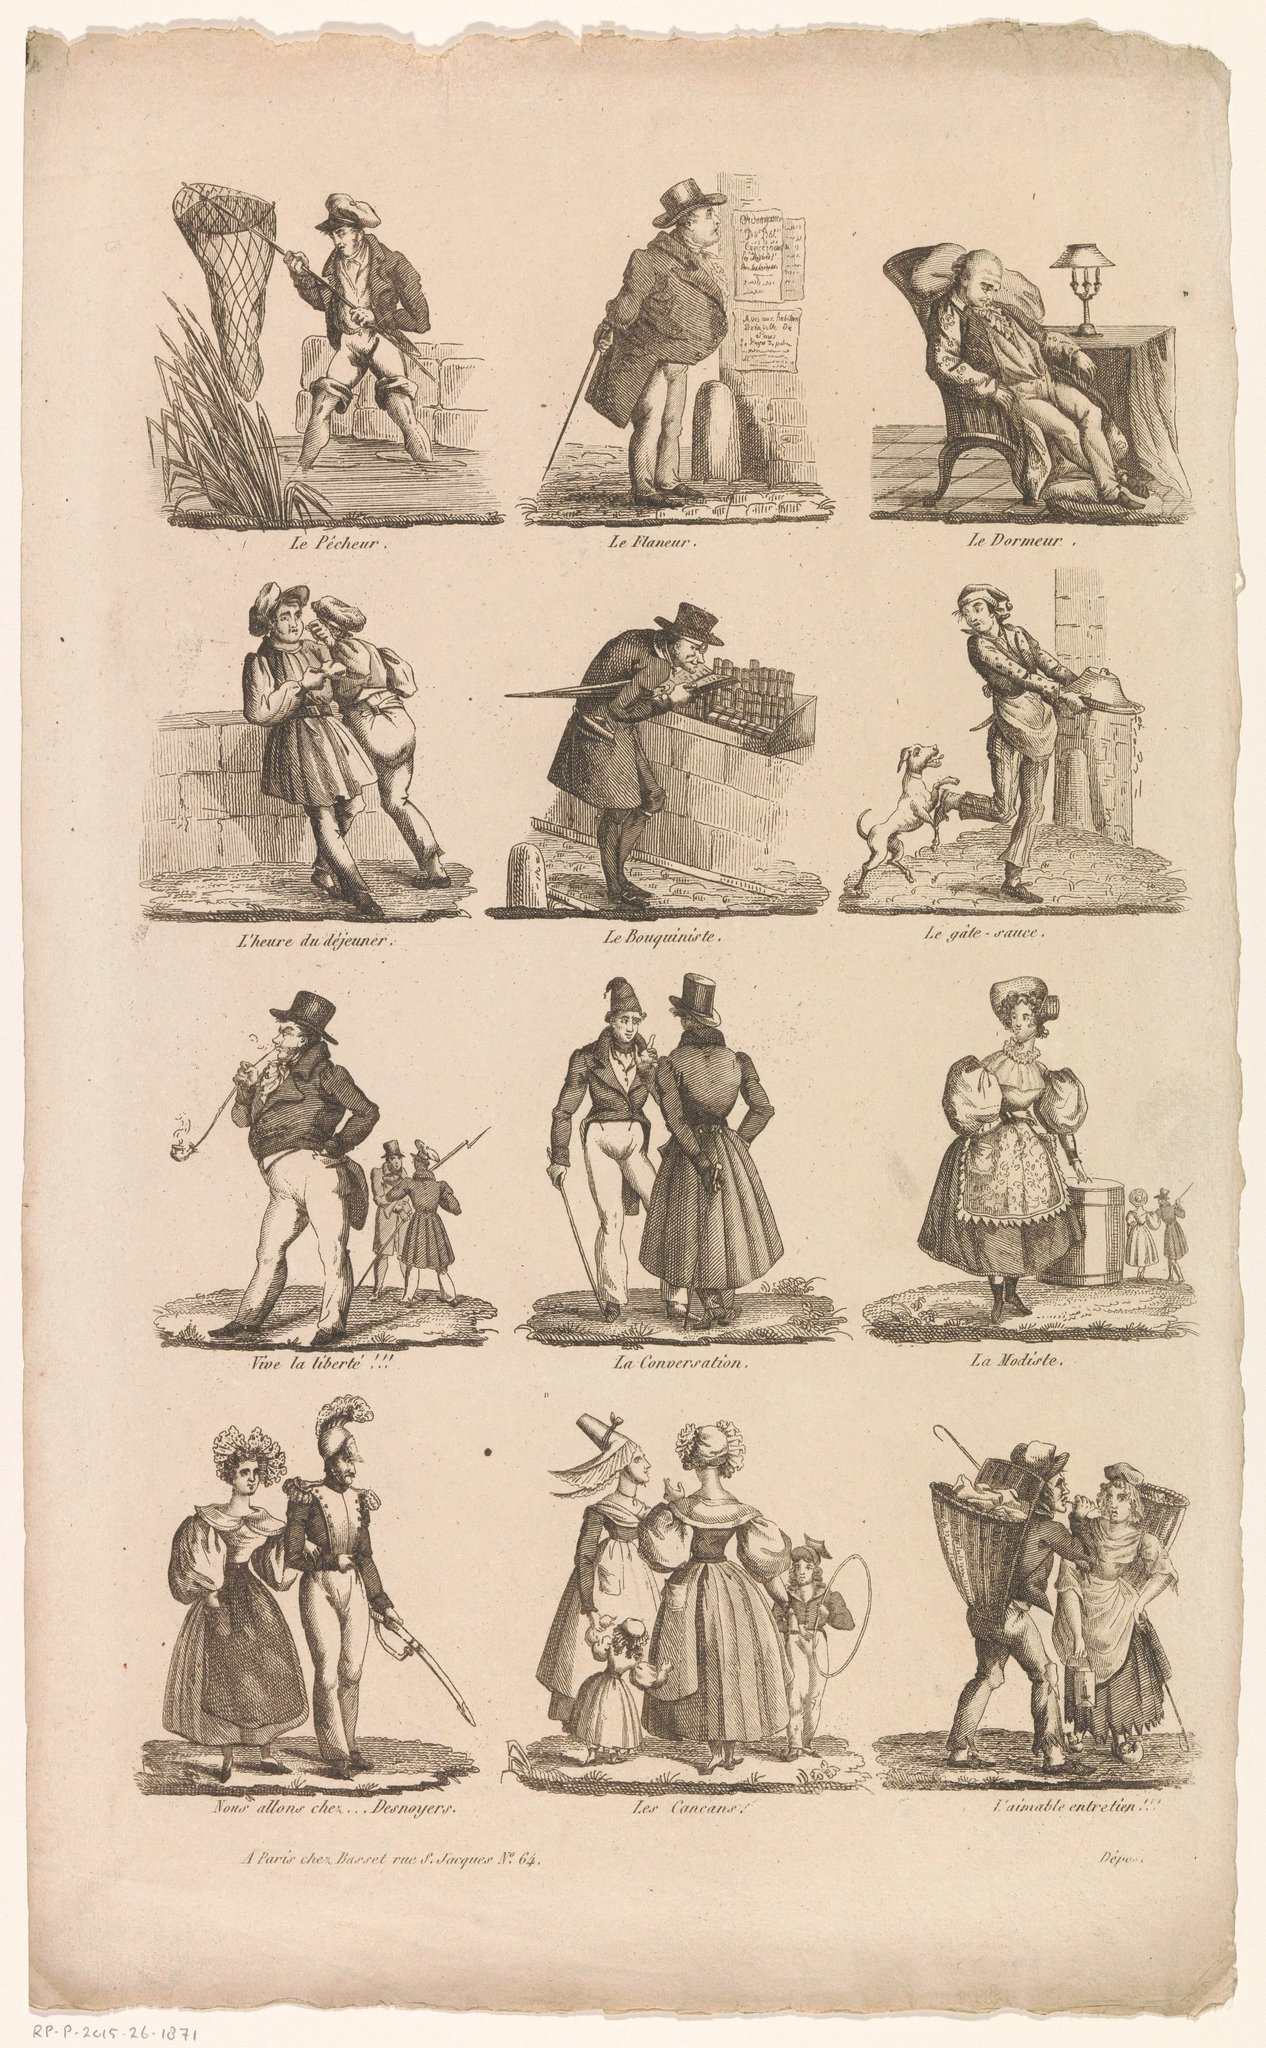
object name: print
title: Blad met twaalf genretaferelen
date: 1812-1885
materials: paper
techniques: etching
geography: paris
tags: sleeping in chair, book-stall, kiosk, private soldier, pipe ~ tobacco, fishing (sports)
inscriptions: collector's mark: Lugt 4779, collector's mark: Lugt 2228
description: Elk tafereel met een onderschrift in het Frans. Met onder meer een man met een visnet, een slapende man in een stoel, een man voor een boekenkraam, een pijp rokende man en twee vrouwen met kinderen.